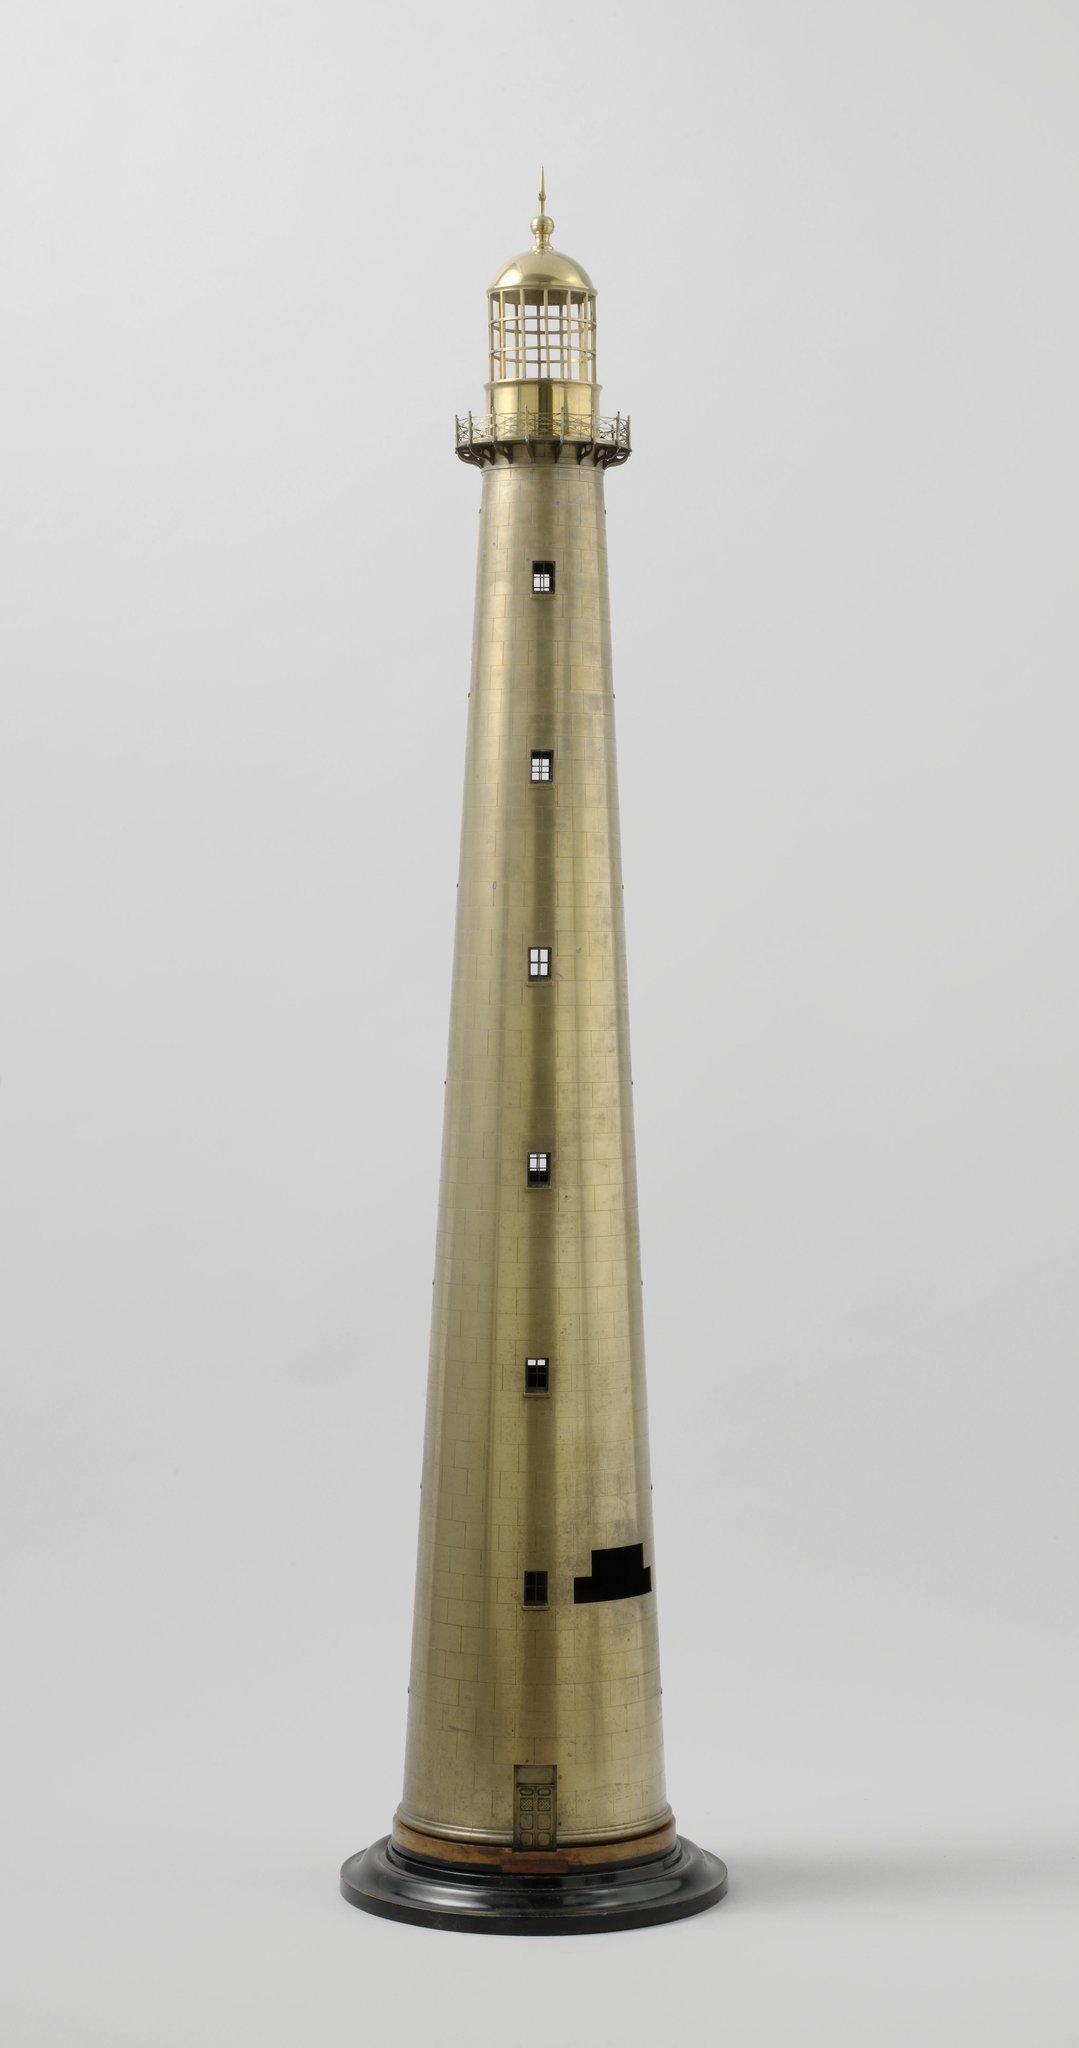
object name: scale model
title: Model of the Ameland Lighthouse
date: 1880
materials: brass, wood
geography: deventer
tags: lighthouse, lightship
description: Quirinus Harder was the most important Dutch designer of lighthouses in the second half of the 19th century. His last design was the round (nowadays red-and-white banded) lighthouse of Ameland (Hollum); at 55 meters, it ranks among the tallest in the Netherlands. The tower wall consists of cast-iron segments that can be assembled like a do-it-yourself kit on site. It has served as a beacon to guide ships since 10 May 1881.